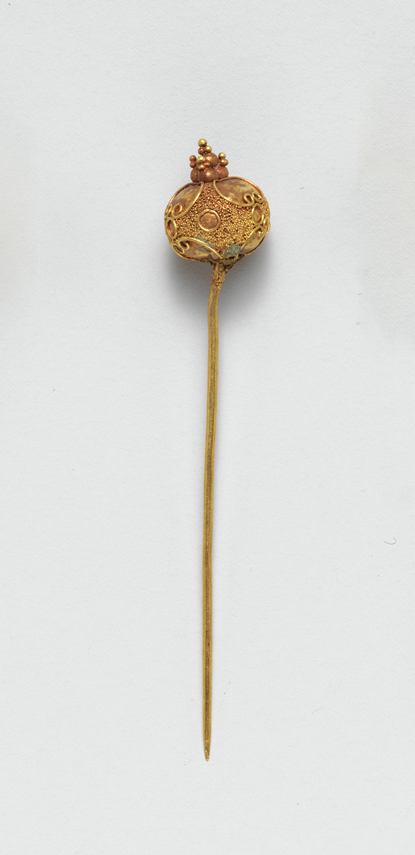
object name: pin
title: Gold pin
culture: etruscan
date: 500-401 BCE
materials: gold